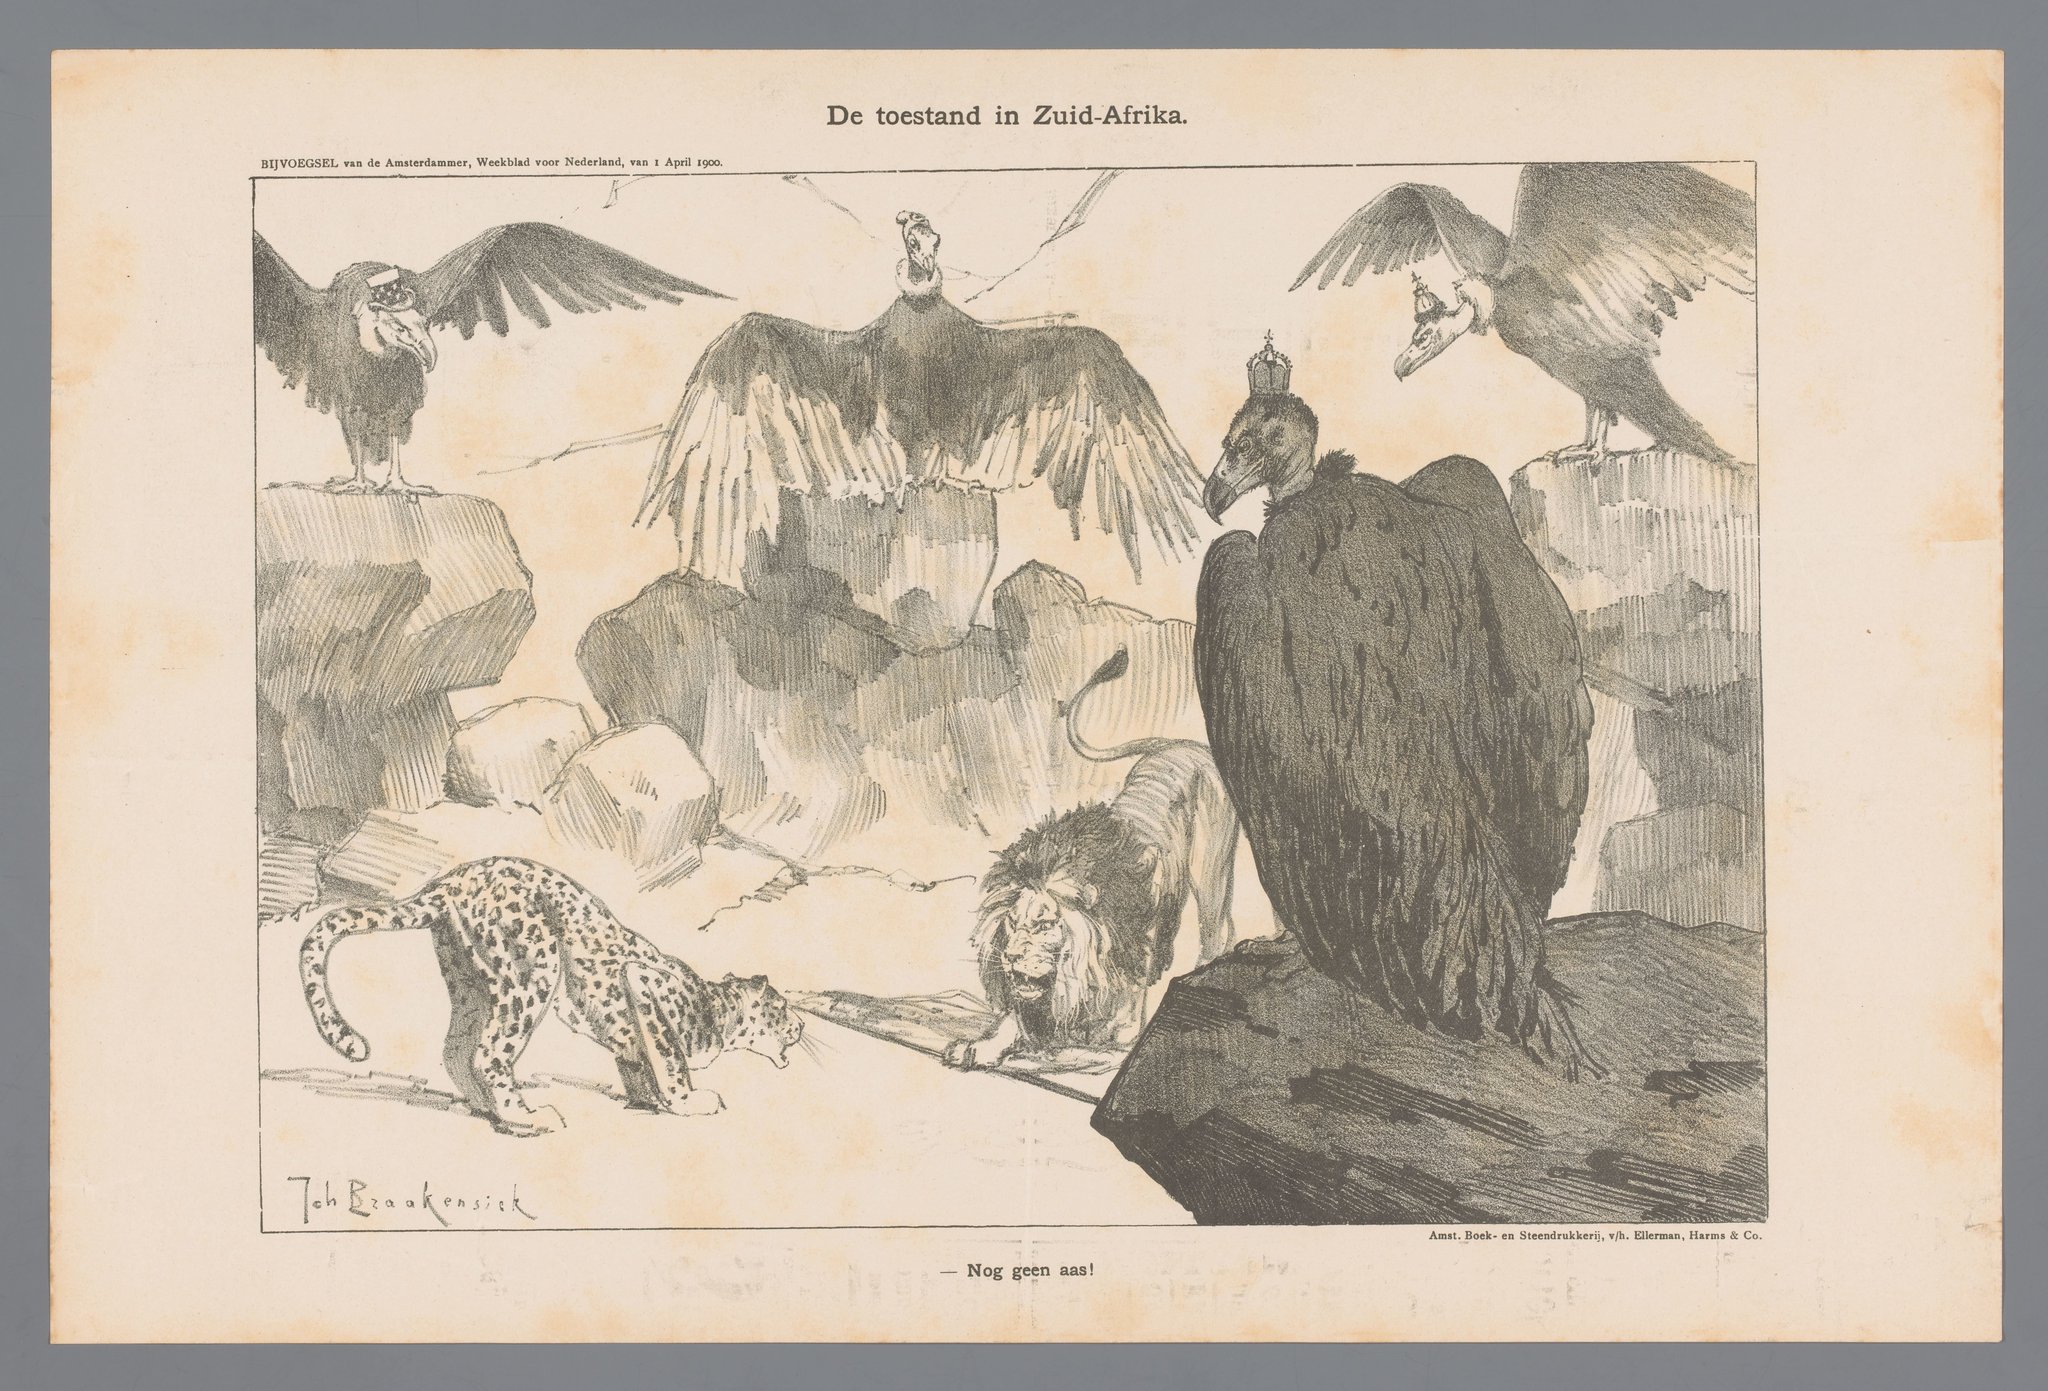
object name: cartoon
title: De toestand in Zuid-Afrika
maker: johan braakensiek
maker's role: draughtsman, print maker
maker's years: 1858-1940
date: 1900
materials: paper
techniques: lithograph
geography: amsterdam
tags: personifications of countries, nations, states, districts, etc., predatory birds: vulture, beasts of prey, predatory animals: lion, political caricatures and satires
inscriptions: date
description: Prent uit het bijvoegsel van: De Amsterdammer. Weekblad voor Nederland, 1 april 1900.